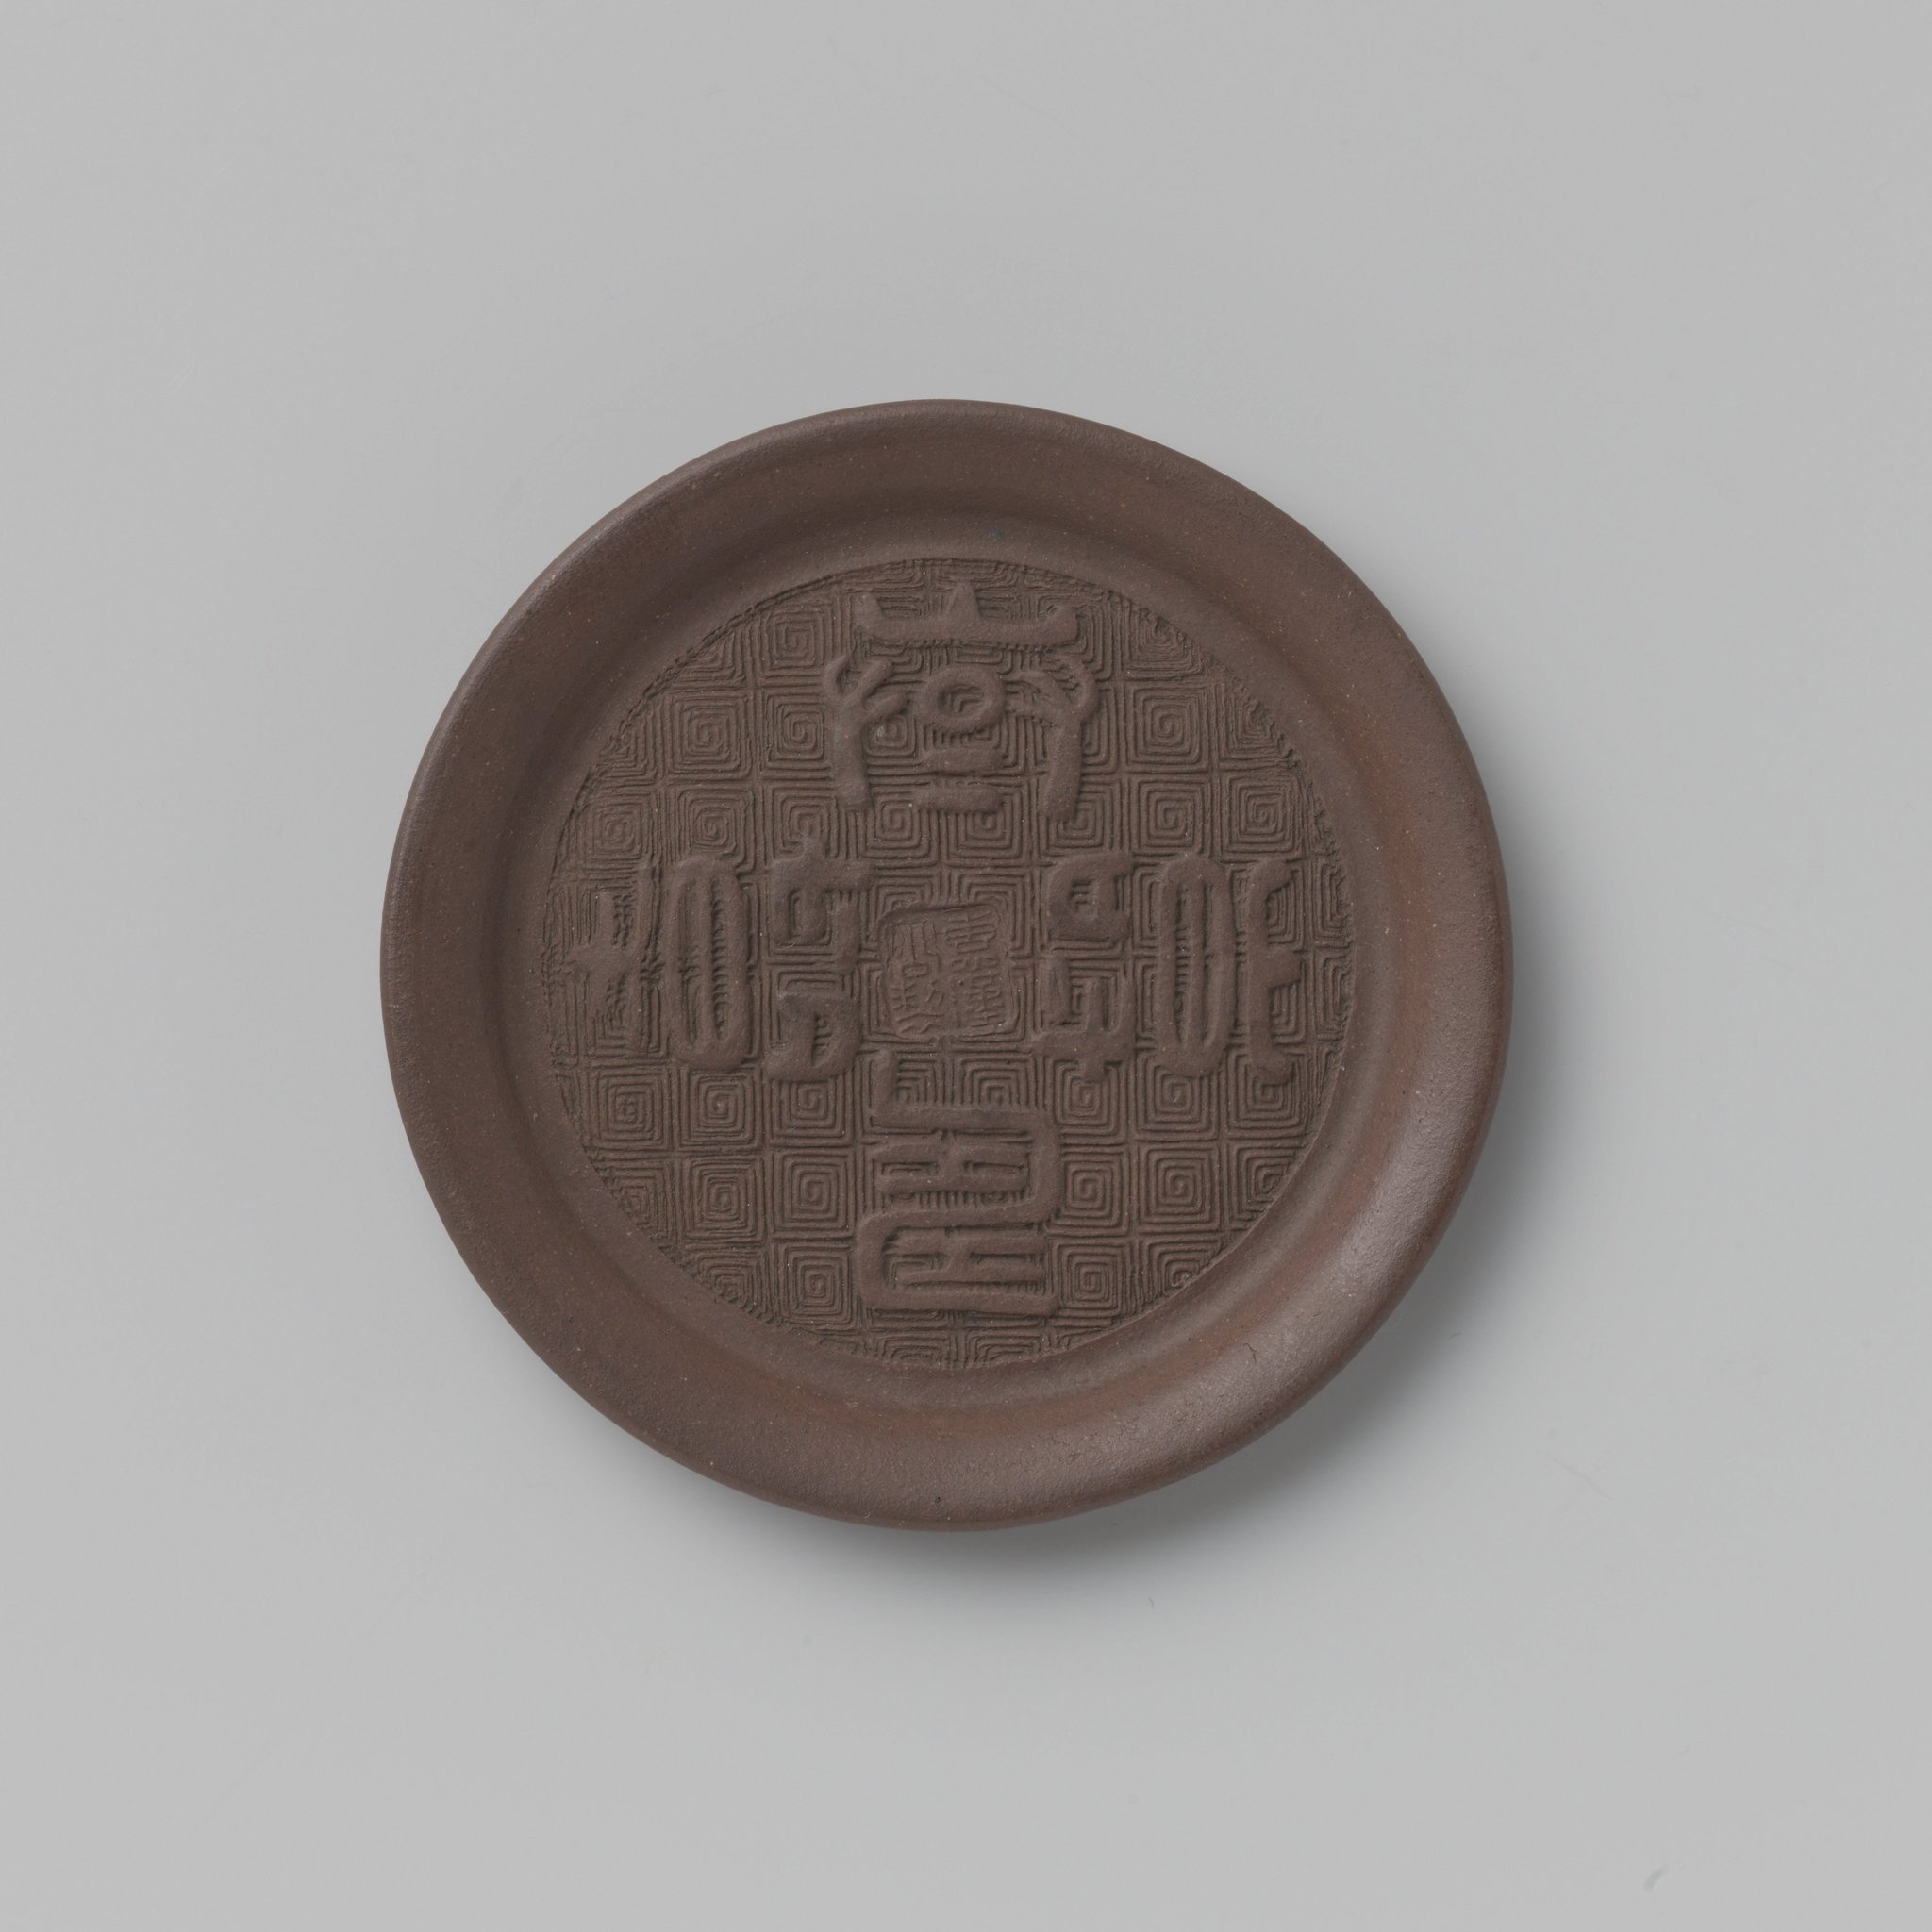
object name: platter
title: Dish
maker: Anonymous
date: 1700-1799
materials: stoneware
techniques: firing, relief, turning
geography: china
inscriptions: mark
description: This saucer is decorated with a repeating geometric pattern and four Chinese characters. Written in seal script, these shou characters radiate from the centre to the edges of the dish and signify longevity. The dish’s size and depth suggest that it was used as a coaster for a teapot.